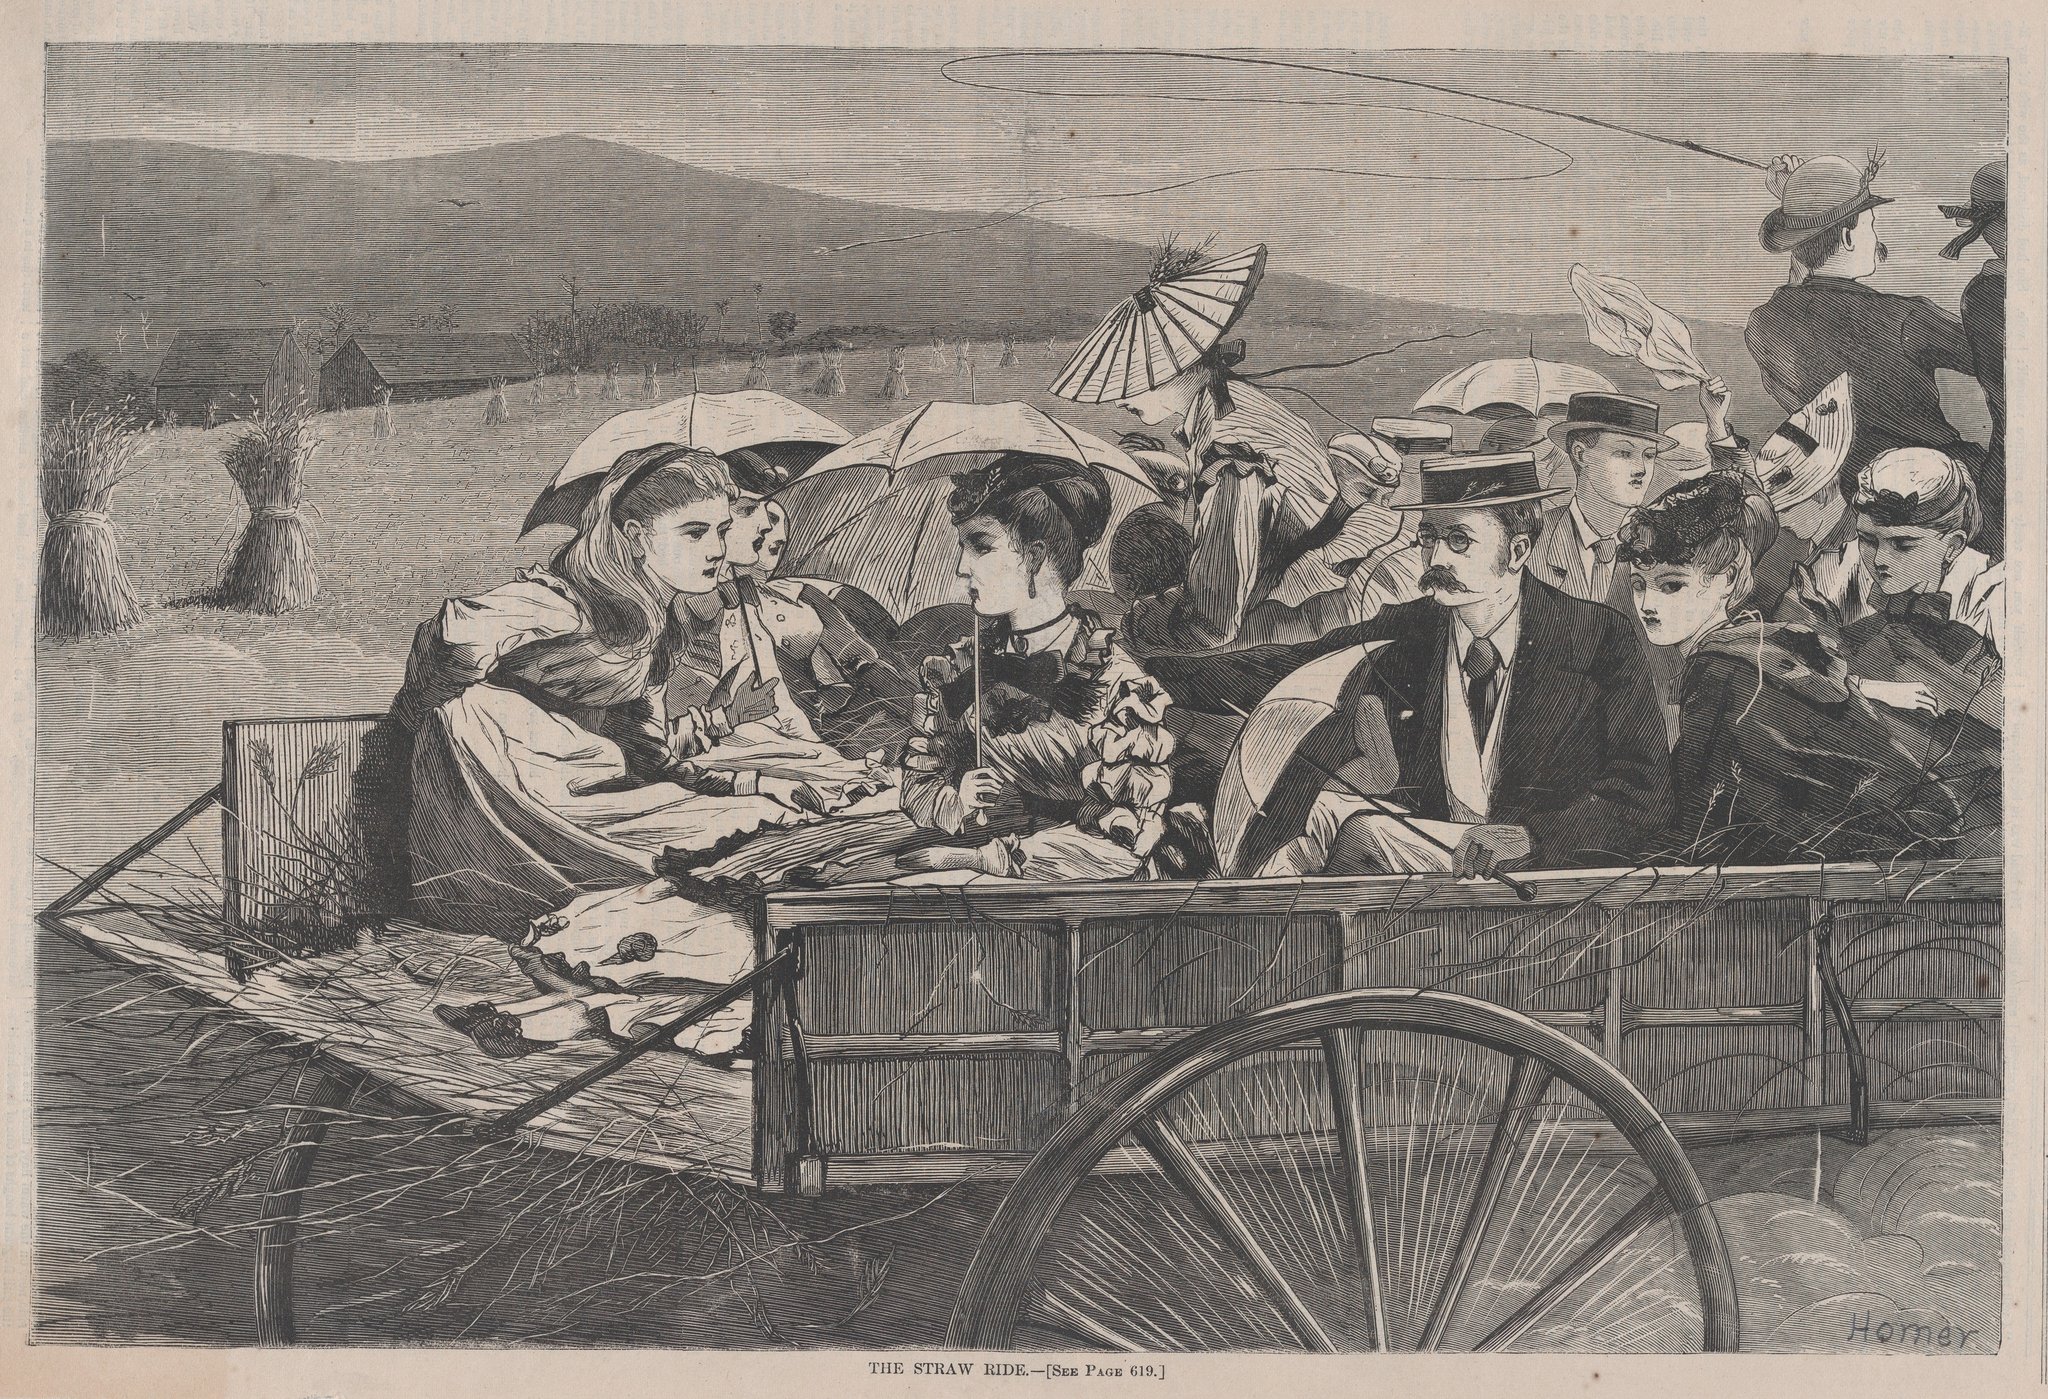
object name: print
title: The Straw Ride (from "Harper's Bazar," Vol. II)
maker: winslow homer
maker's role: artist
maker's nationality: american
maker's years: 1836-1910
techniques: engraving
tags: men,women,carriages